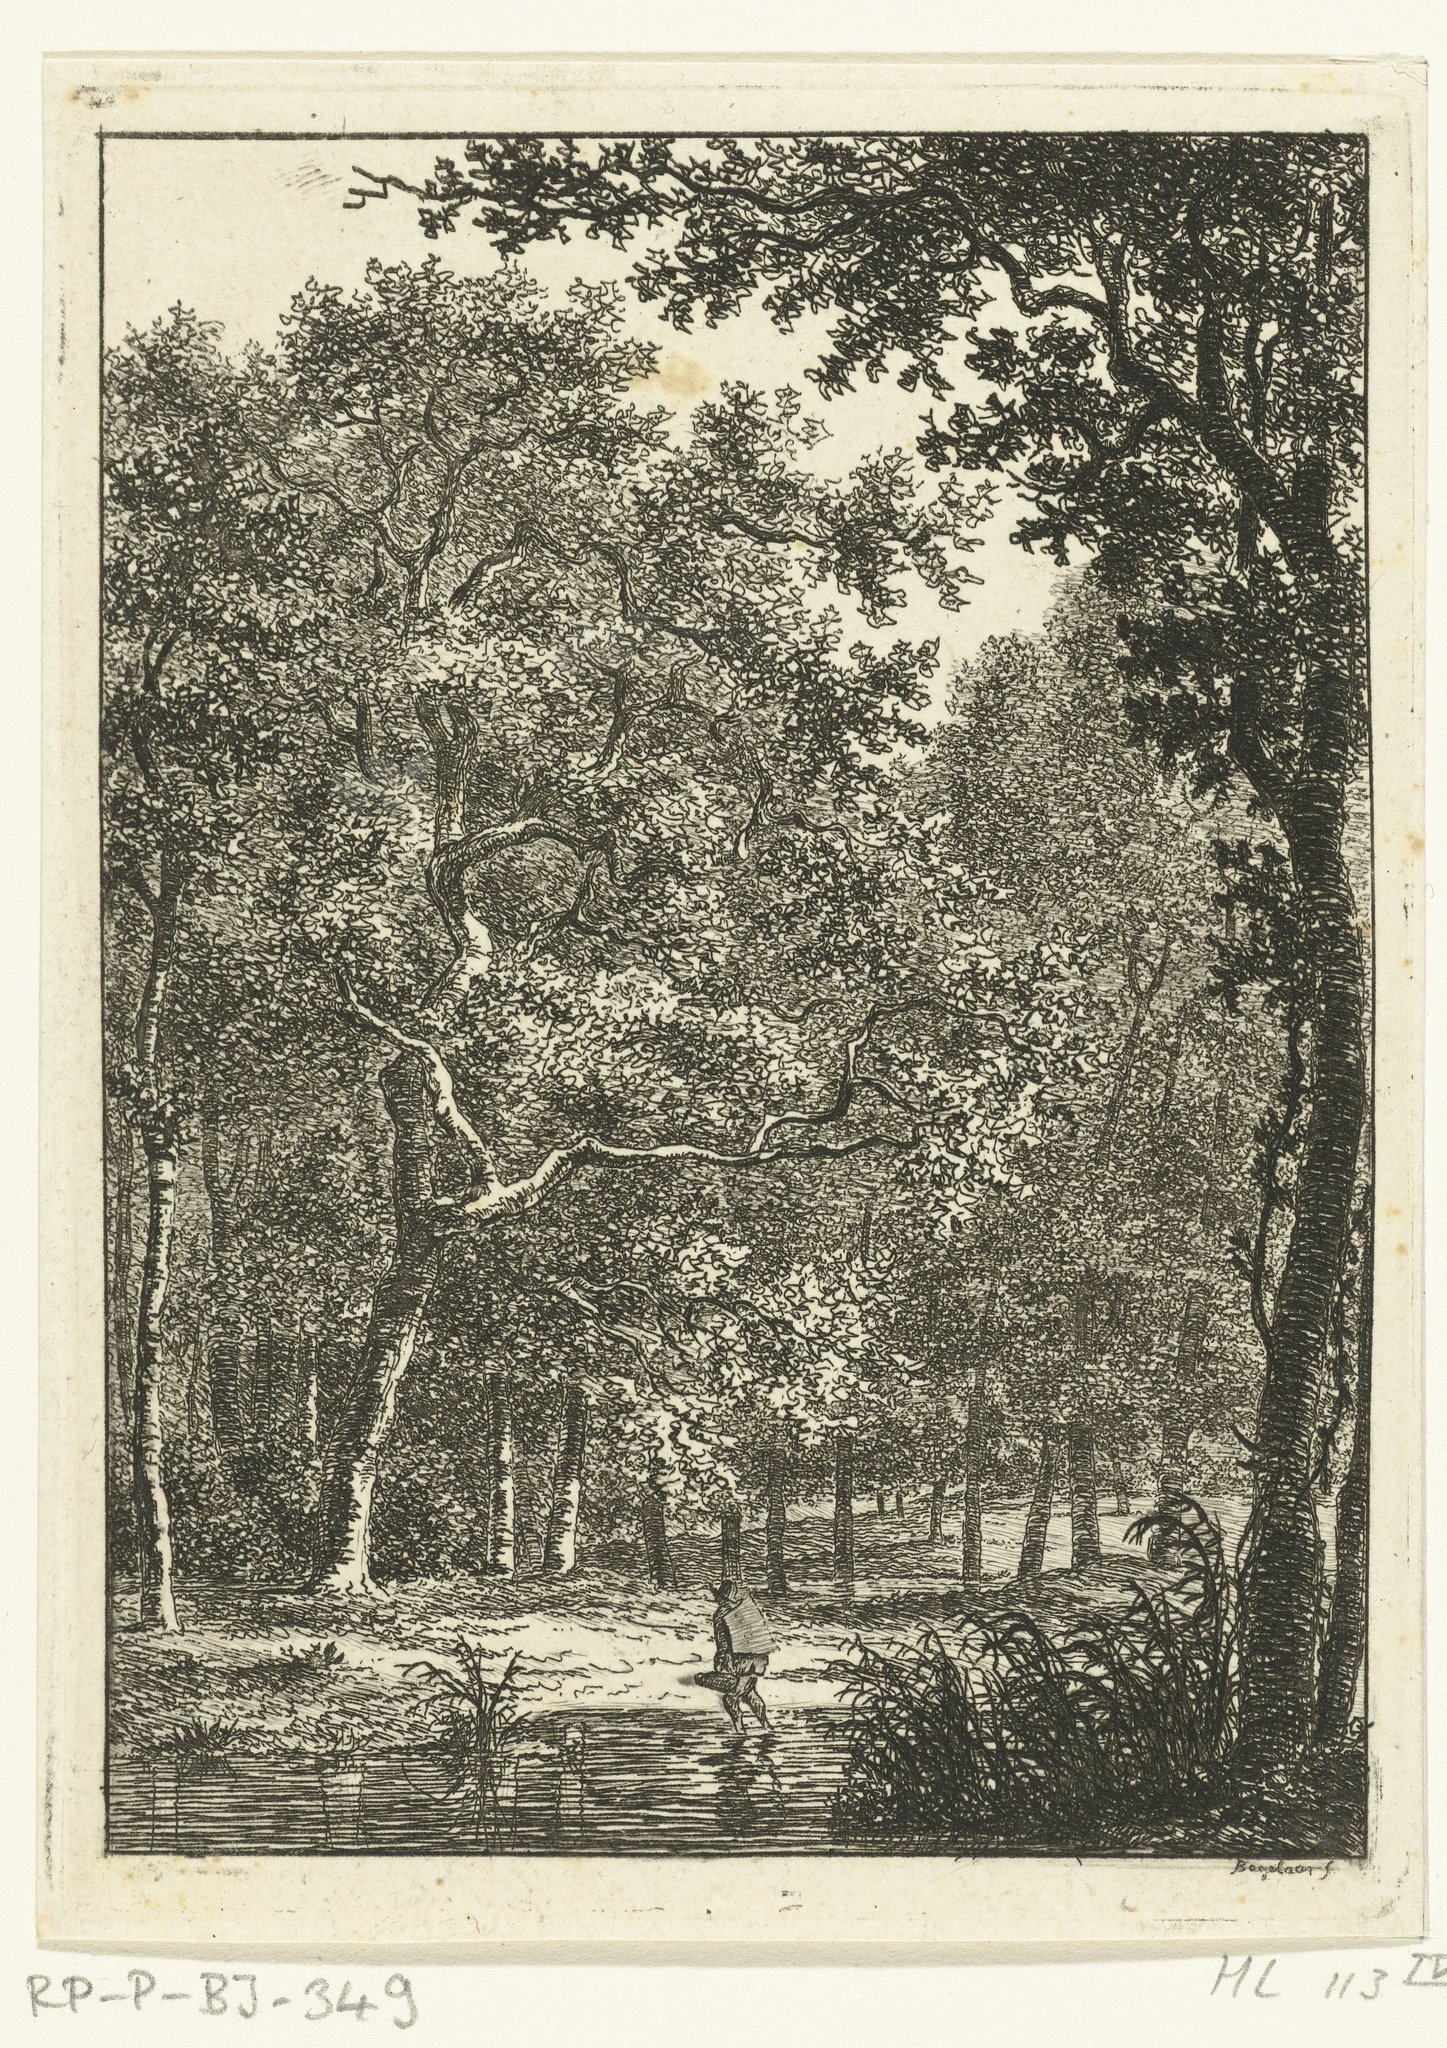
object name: print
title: Boslandschap met man die door water waadt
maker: ernst willem jan bagelaar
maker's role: draughtsman, print maker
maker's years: 1775-1837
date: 1798-1837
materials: paper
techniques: drypoint, etching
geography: netherlands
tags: forest, wood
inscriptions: collector's mark: Lugt 2228